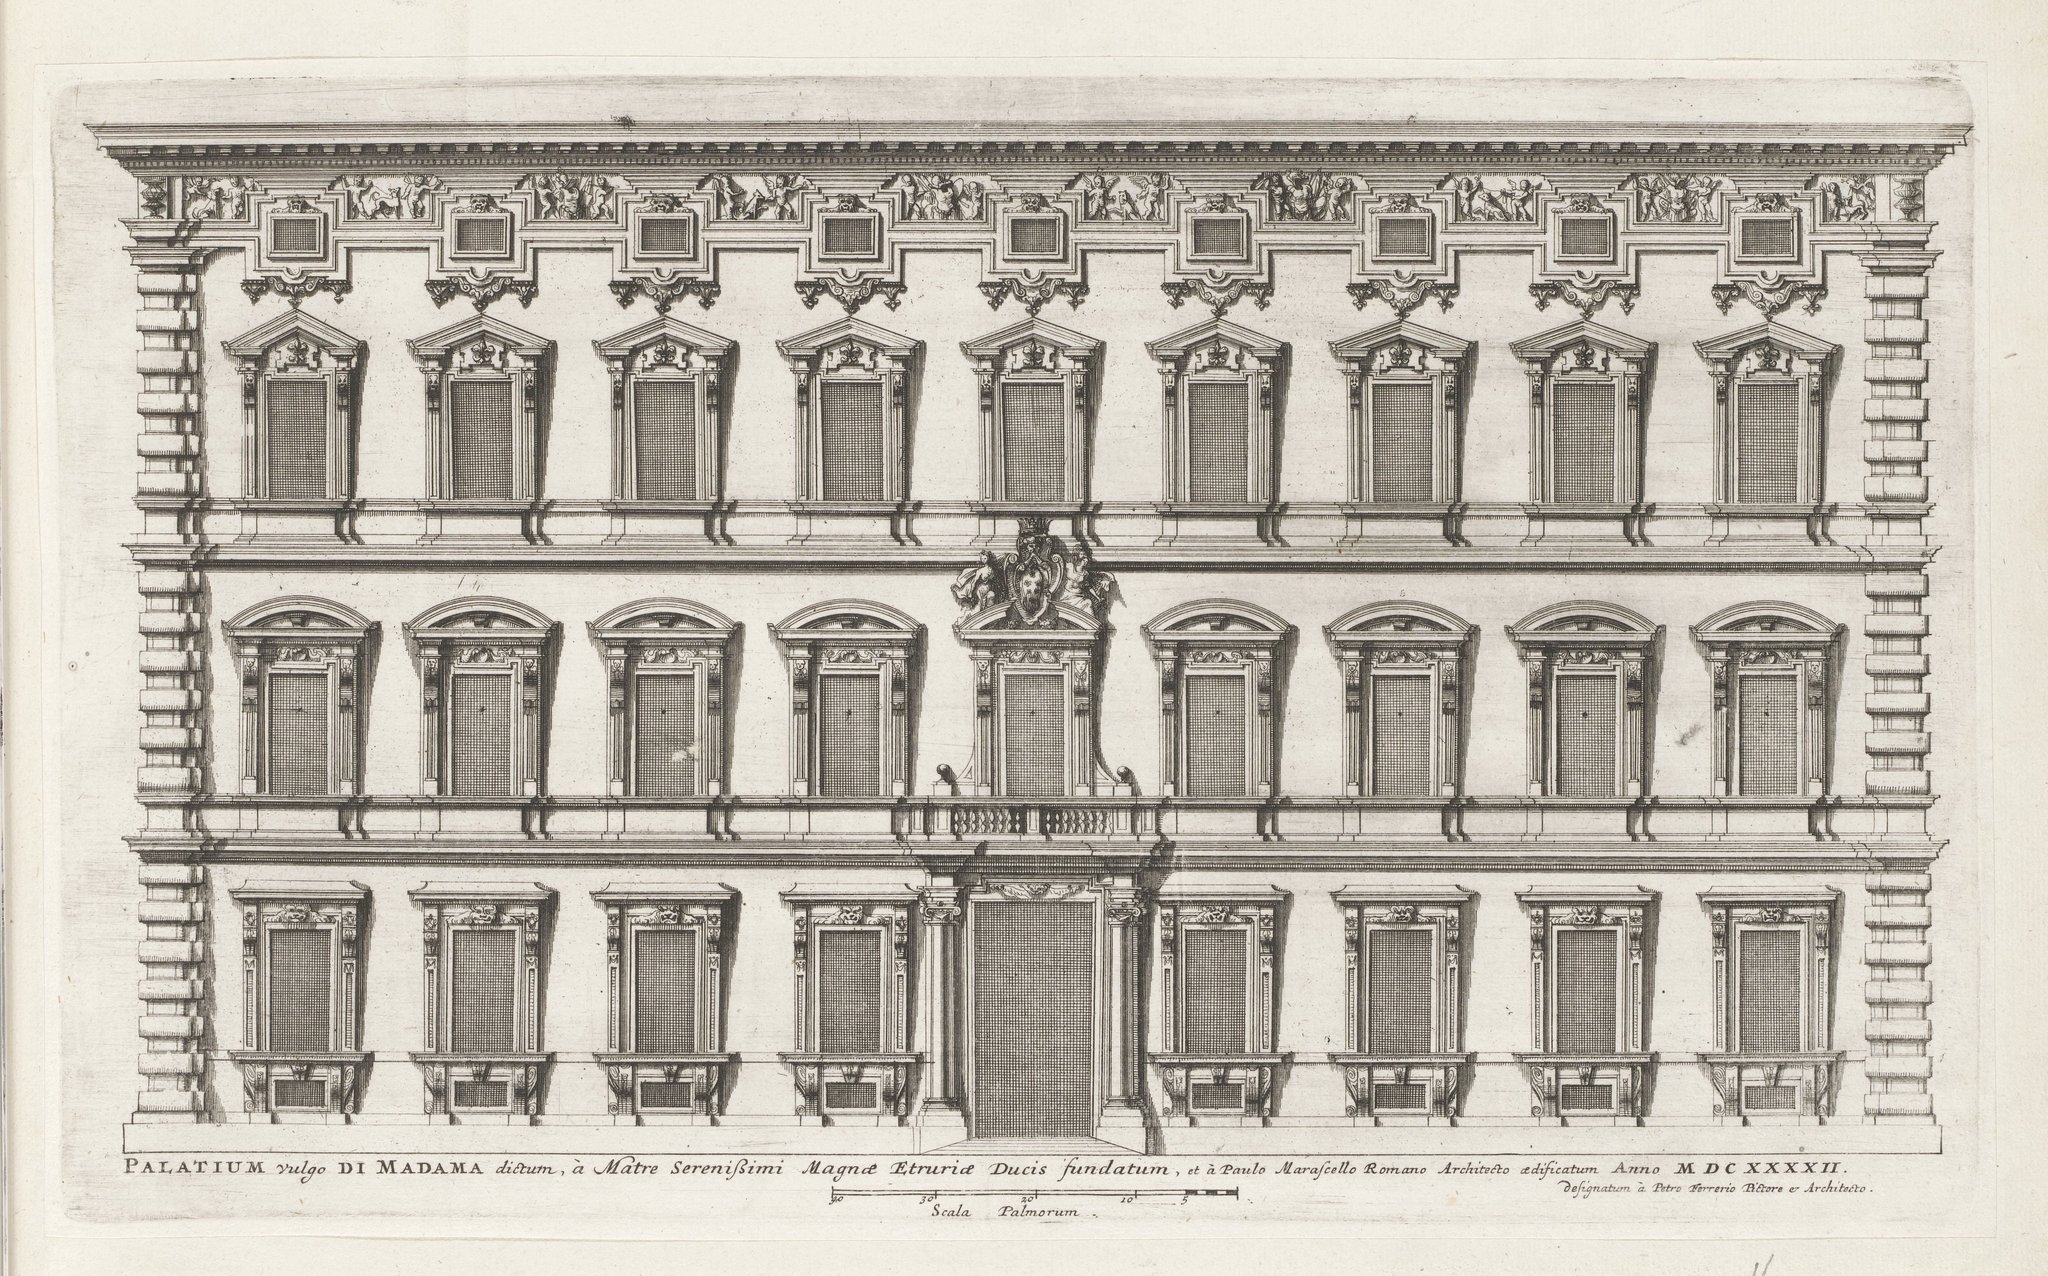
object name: album leaf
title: Palatium vulgo di Madam (...)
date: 1655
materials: paper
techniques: etching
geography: rome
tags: palace, façade (of house or building)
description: Deze prent maakt deel uit van de reeks getiteld: Palazzi di Roma. Deze reeks bestaat uit twee boeken. Boek één getiteld: Palazzi di Roma dei più celebri architetti..., bestaat uit 44 prenten die worden toegeschreven aan Giovanni Battista Falda (naam staat enkel op prent 27) en uitgegeven door Giovanni Giacomo de'Rossi. Deze 44 prenten zijn bekend in twee staten (met en zonder nummer). Boek twee getiteld: Nuovi disegni dell'architetture... libro secondo, bevat 66 prenten door Giovanni Battista Falda en Simone Felice. Deze 66 prenten zijn bekend in twee staten (met en zonder nummer).